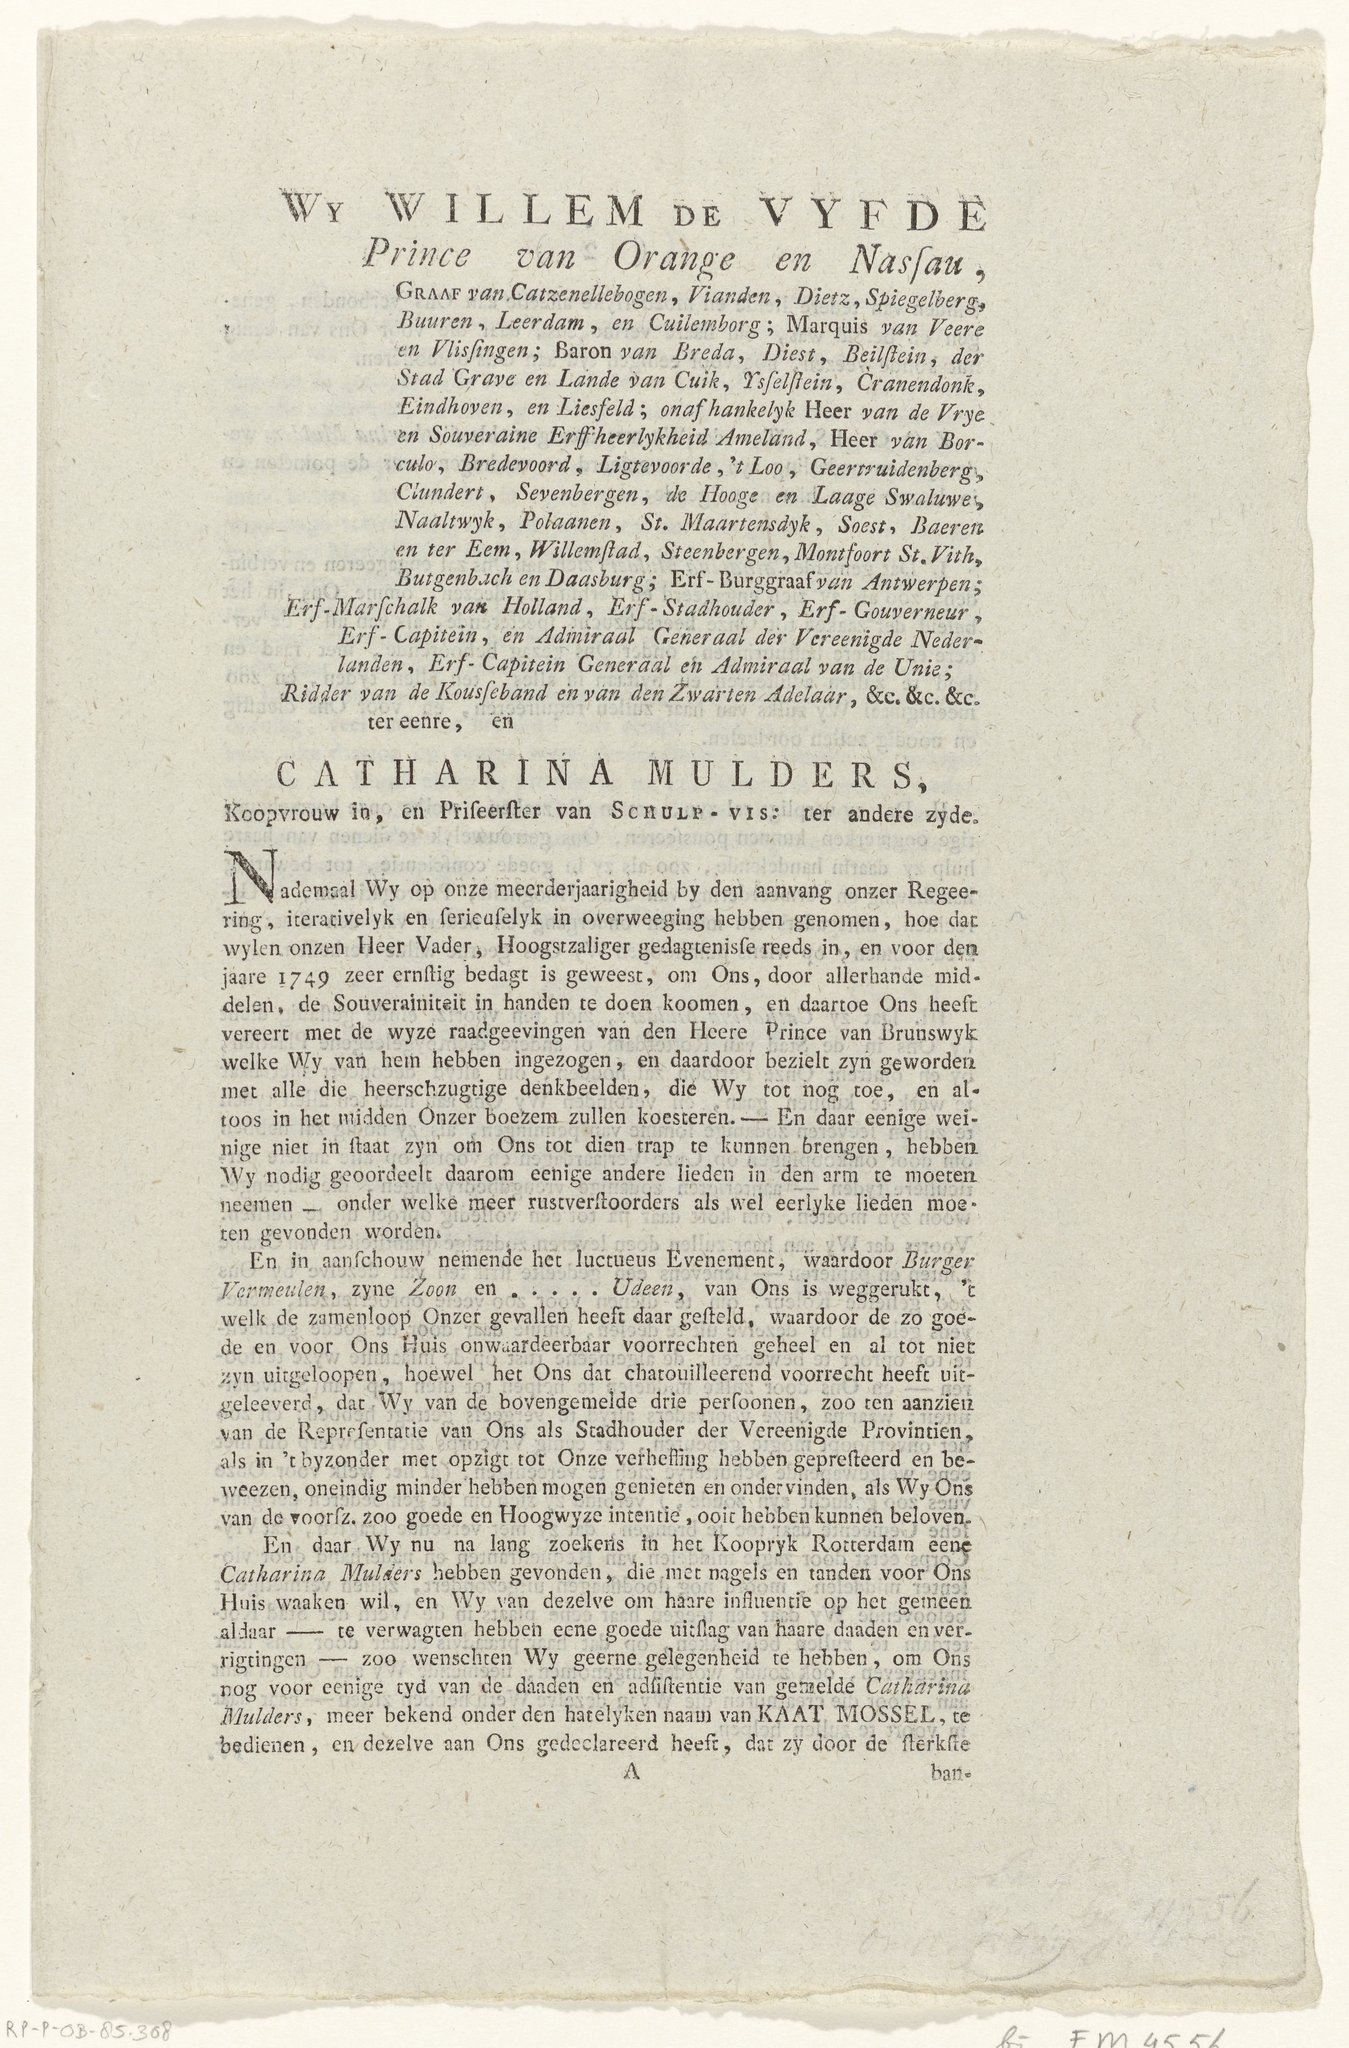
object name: calligraphy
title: Tot Nut van 't Algemeen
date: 1786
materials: paper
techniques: engraving, etching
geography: northern netherlands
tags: haarlem, jan nieuwenhuyzen, printing, printing office, calligraphy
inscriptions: collector's mark: Lugt 2228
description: Kalligrafische voorstelling naar aanleiding van de oprichting van de Maatschappij tot Nut van 't Algemeen op 16 november 1784. Bovenaan een portret van de oprichter Jan Nieuwenhuyzen, rechts een medaillon met de Koophandel voorgesteld door kooplieden bij de Schreierstoren te Amsterdam, links een medaillon met een boekdrukkerij en onderaan een voorstelling van een Algemene Vergadering van de Maatschappij in de Oude Lutherse kerk te Amsterdam.